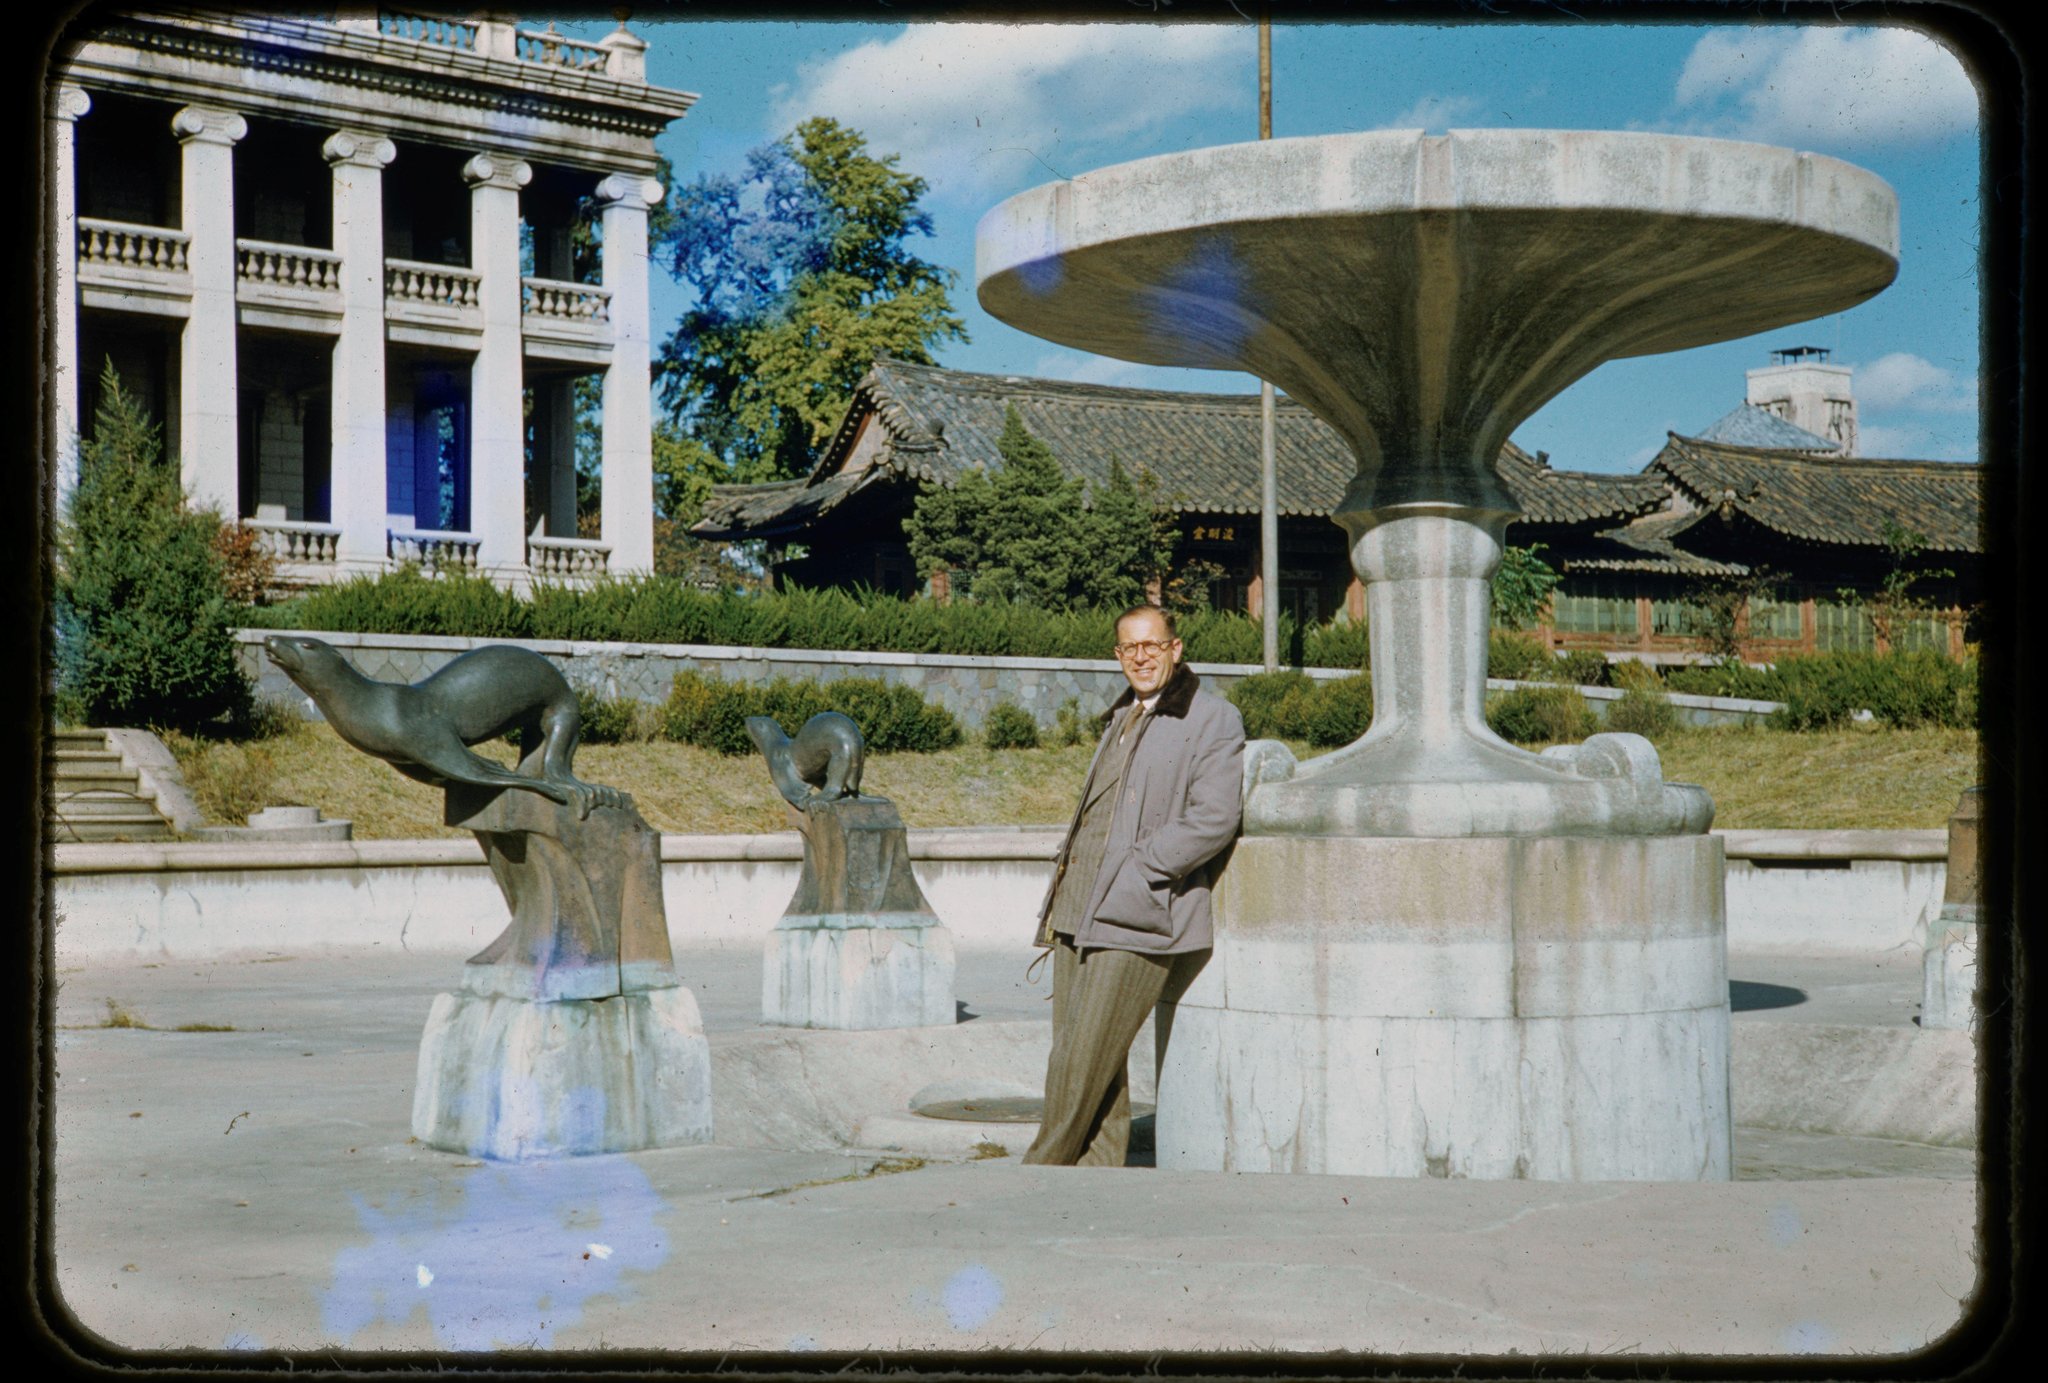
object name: color slide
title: David Ketel voor een paleis in Seoul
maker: david ketel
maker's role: diplomaat, sinoloog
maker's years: 1913-2008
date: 1910-1952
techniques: slide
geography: seoul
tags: united nations, switzerland, david ketel